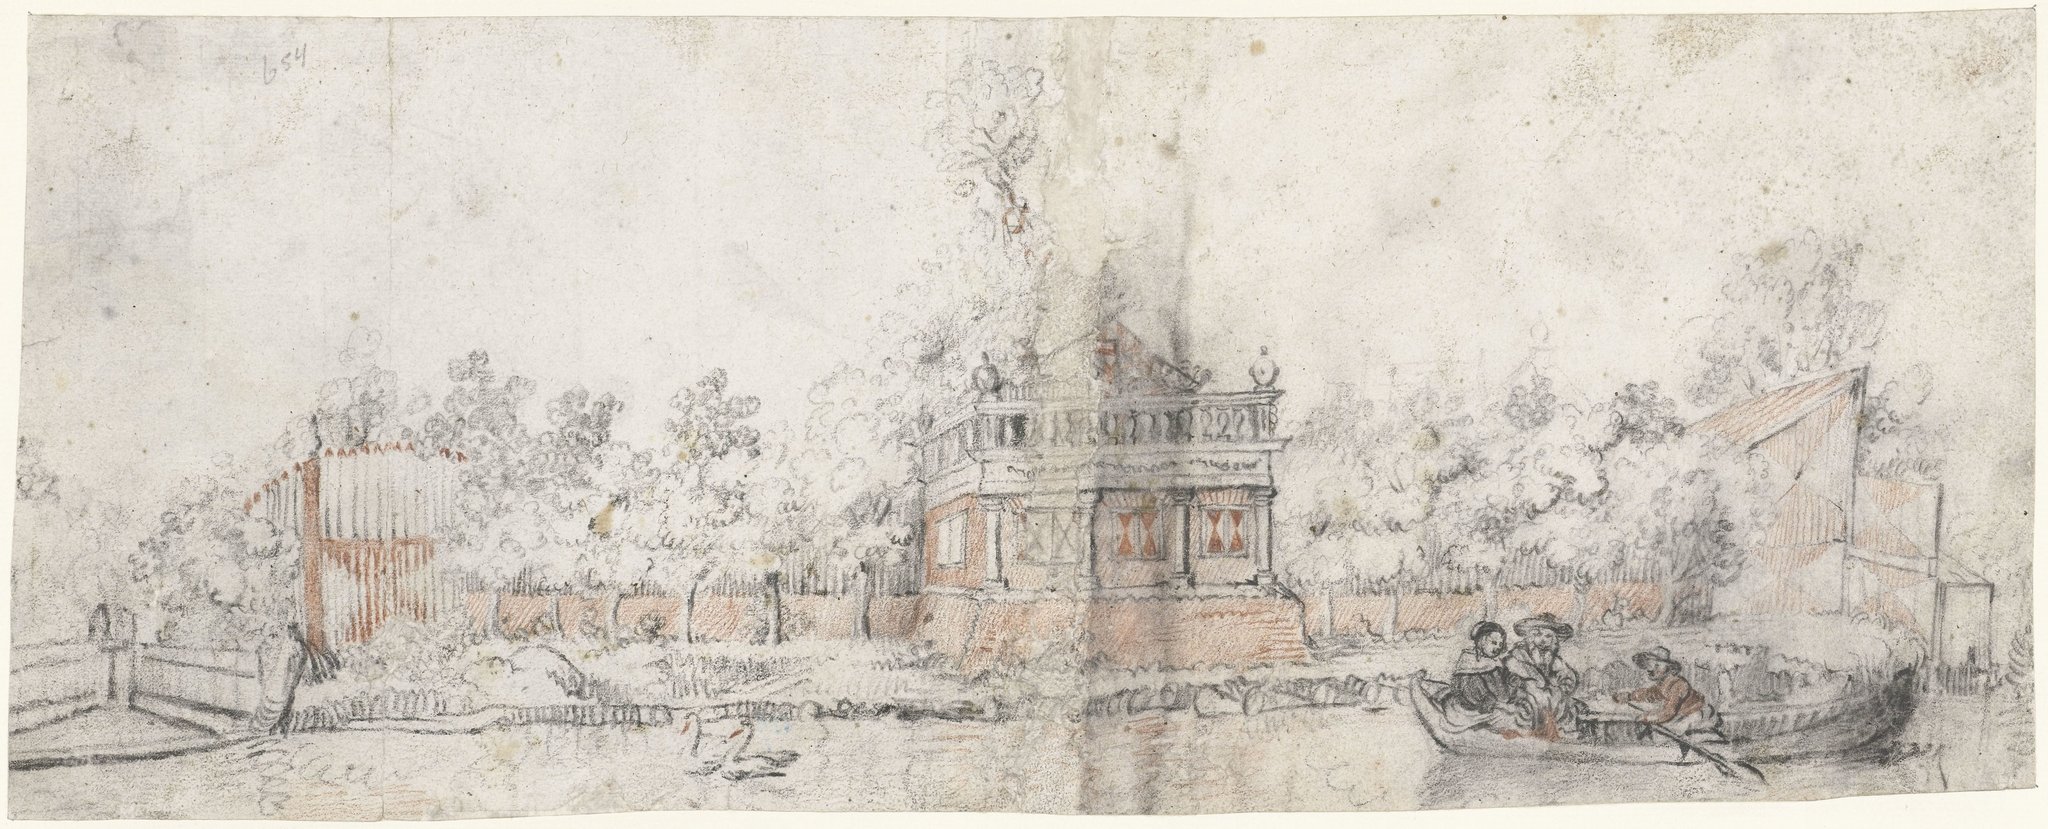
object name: drawing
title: Rivierscène met gezelschap op een boot en een prieel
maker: gesina ter borch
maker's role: draughtsman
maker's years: 1633-1690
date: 1655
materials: chalk, paper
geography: zwolle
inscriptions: watermark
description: Voorstudie voor de achtergrond van de pastorale voorstelling op Scrapbook folio 38, gedateerd 1655.